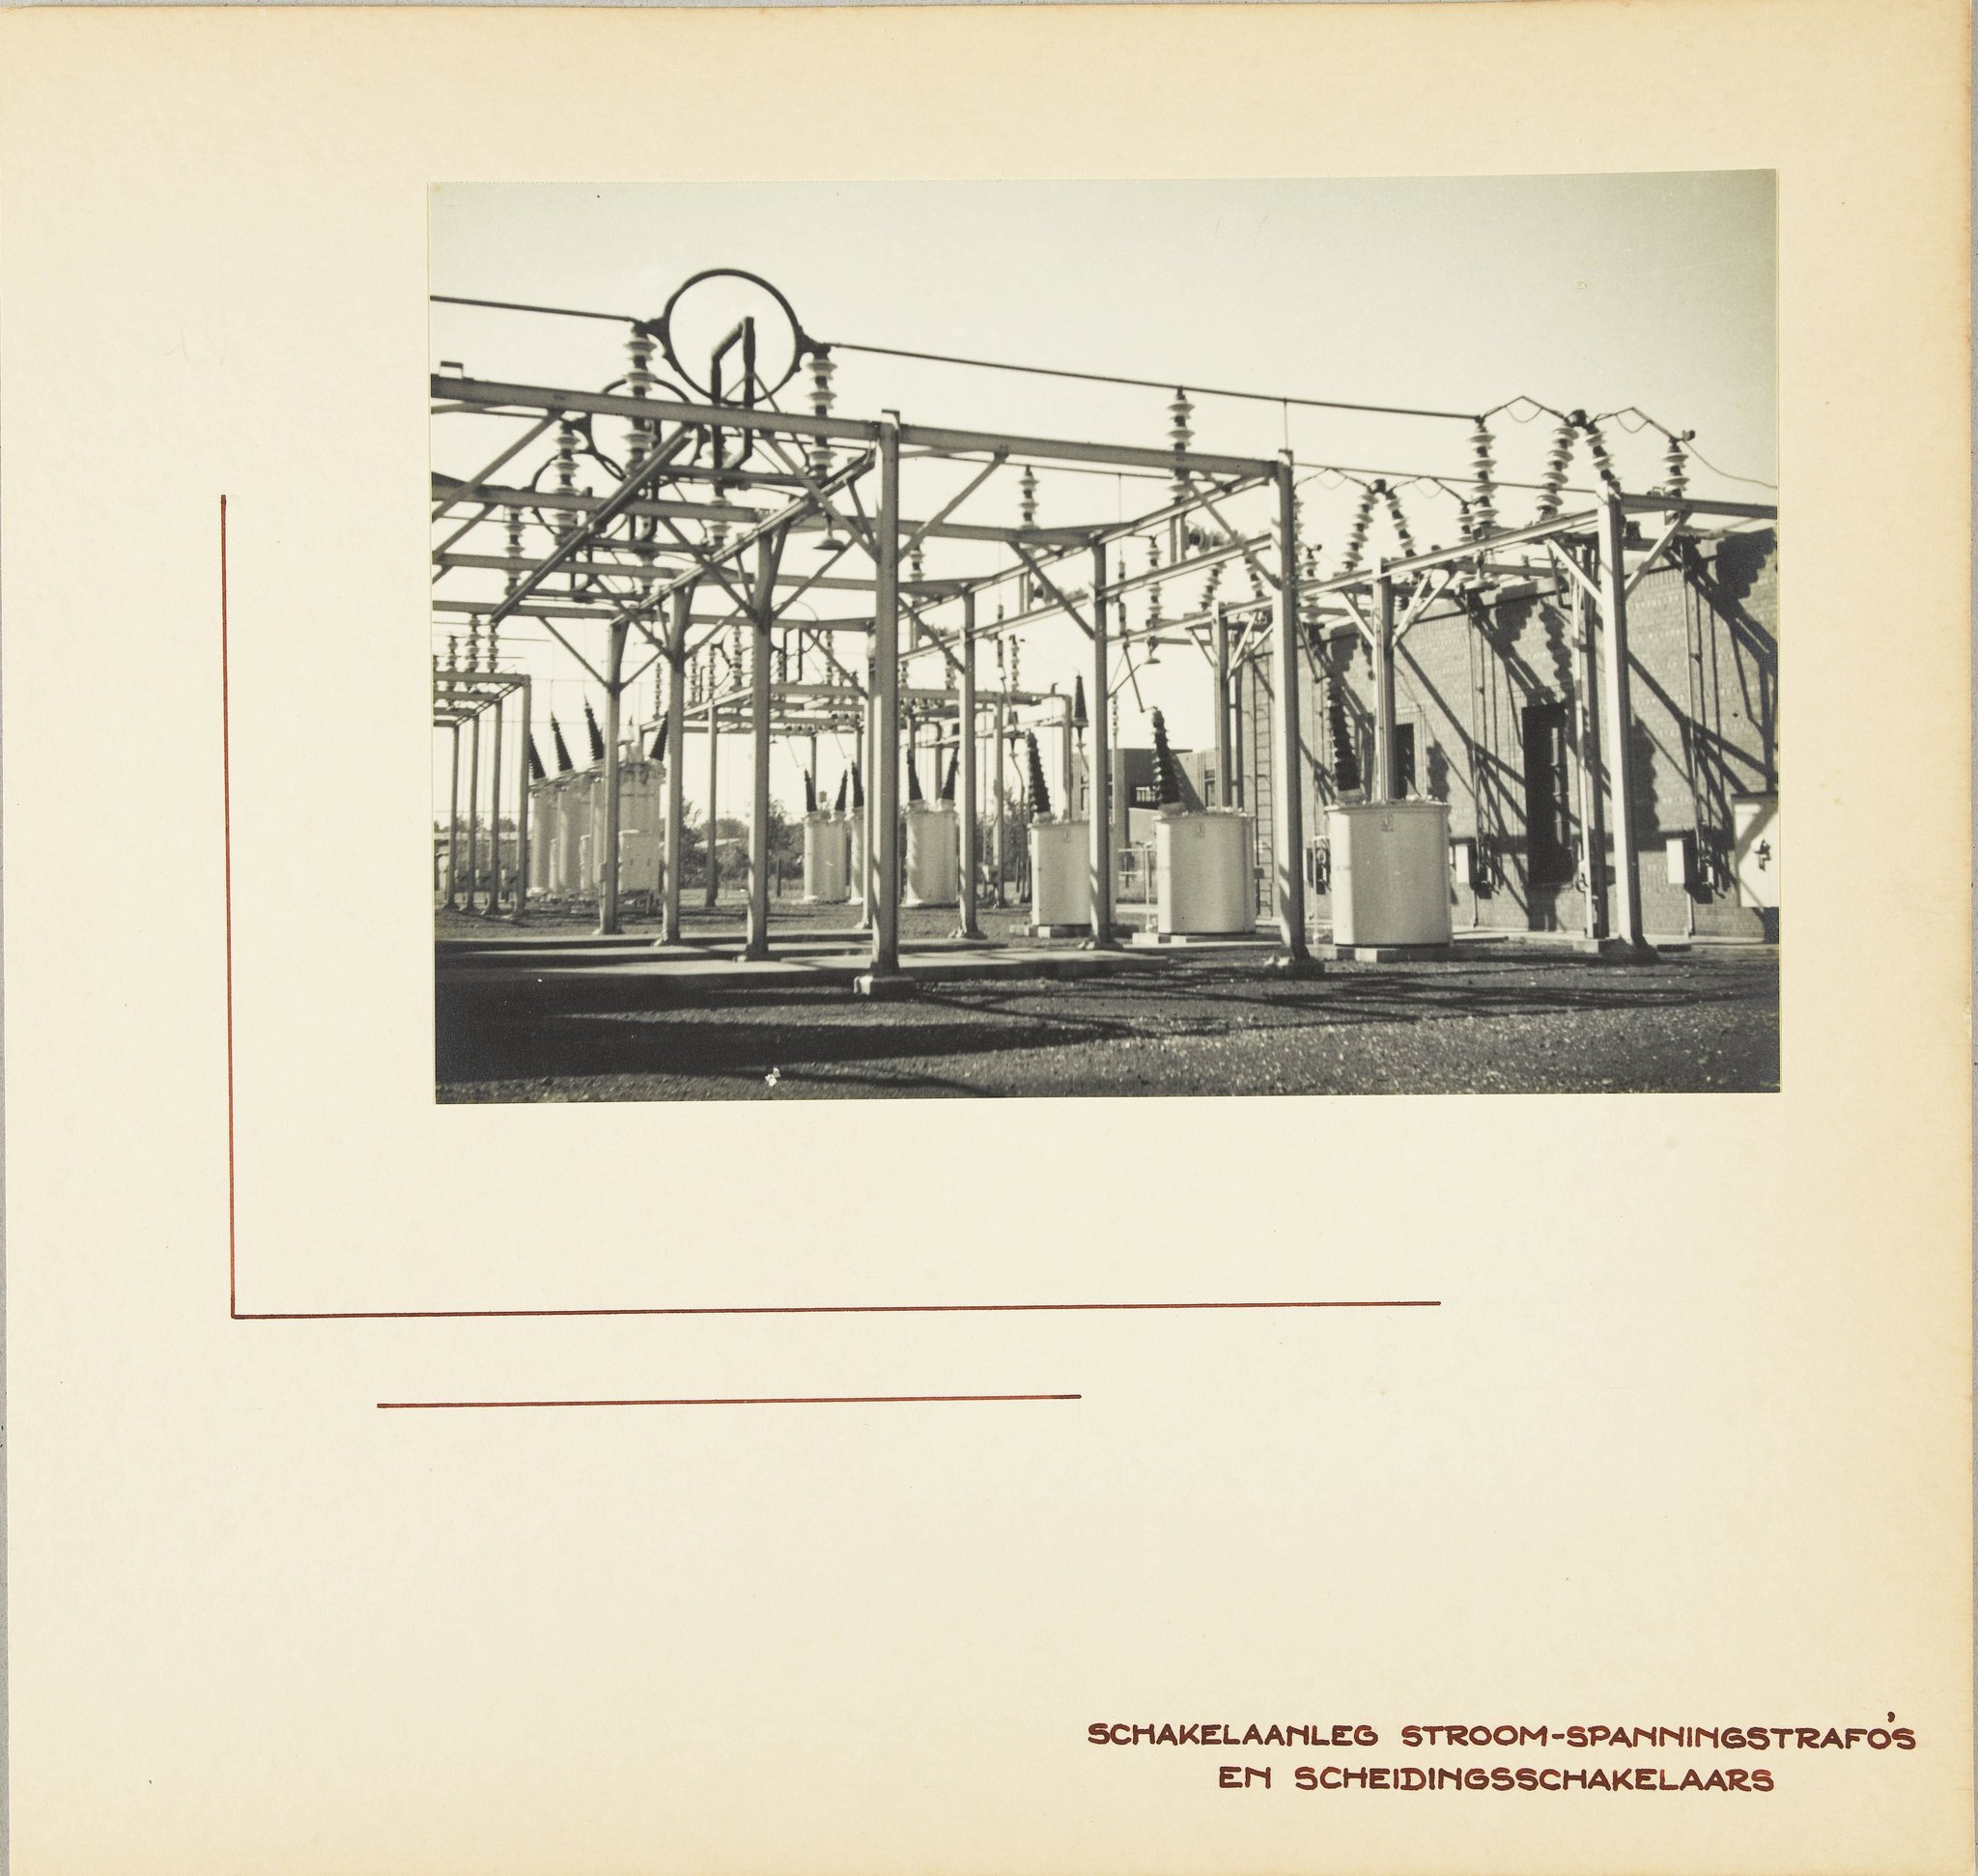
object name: photograph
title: Schakelaanleg stroom-spanningstrafo's en scheidingsschakelaars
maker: wouter cool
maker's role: engineer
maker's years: 1877-1947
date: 1936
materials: cardboard, paper, photographic support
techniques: gelatin silver print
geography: united states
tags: power station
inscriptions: title: ‘SCHAKELAANLEG STROOM-SPANNINGSTRAFO'S / EN SCHEIDINGSSCHAKELAARS’